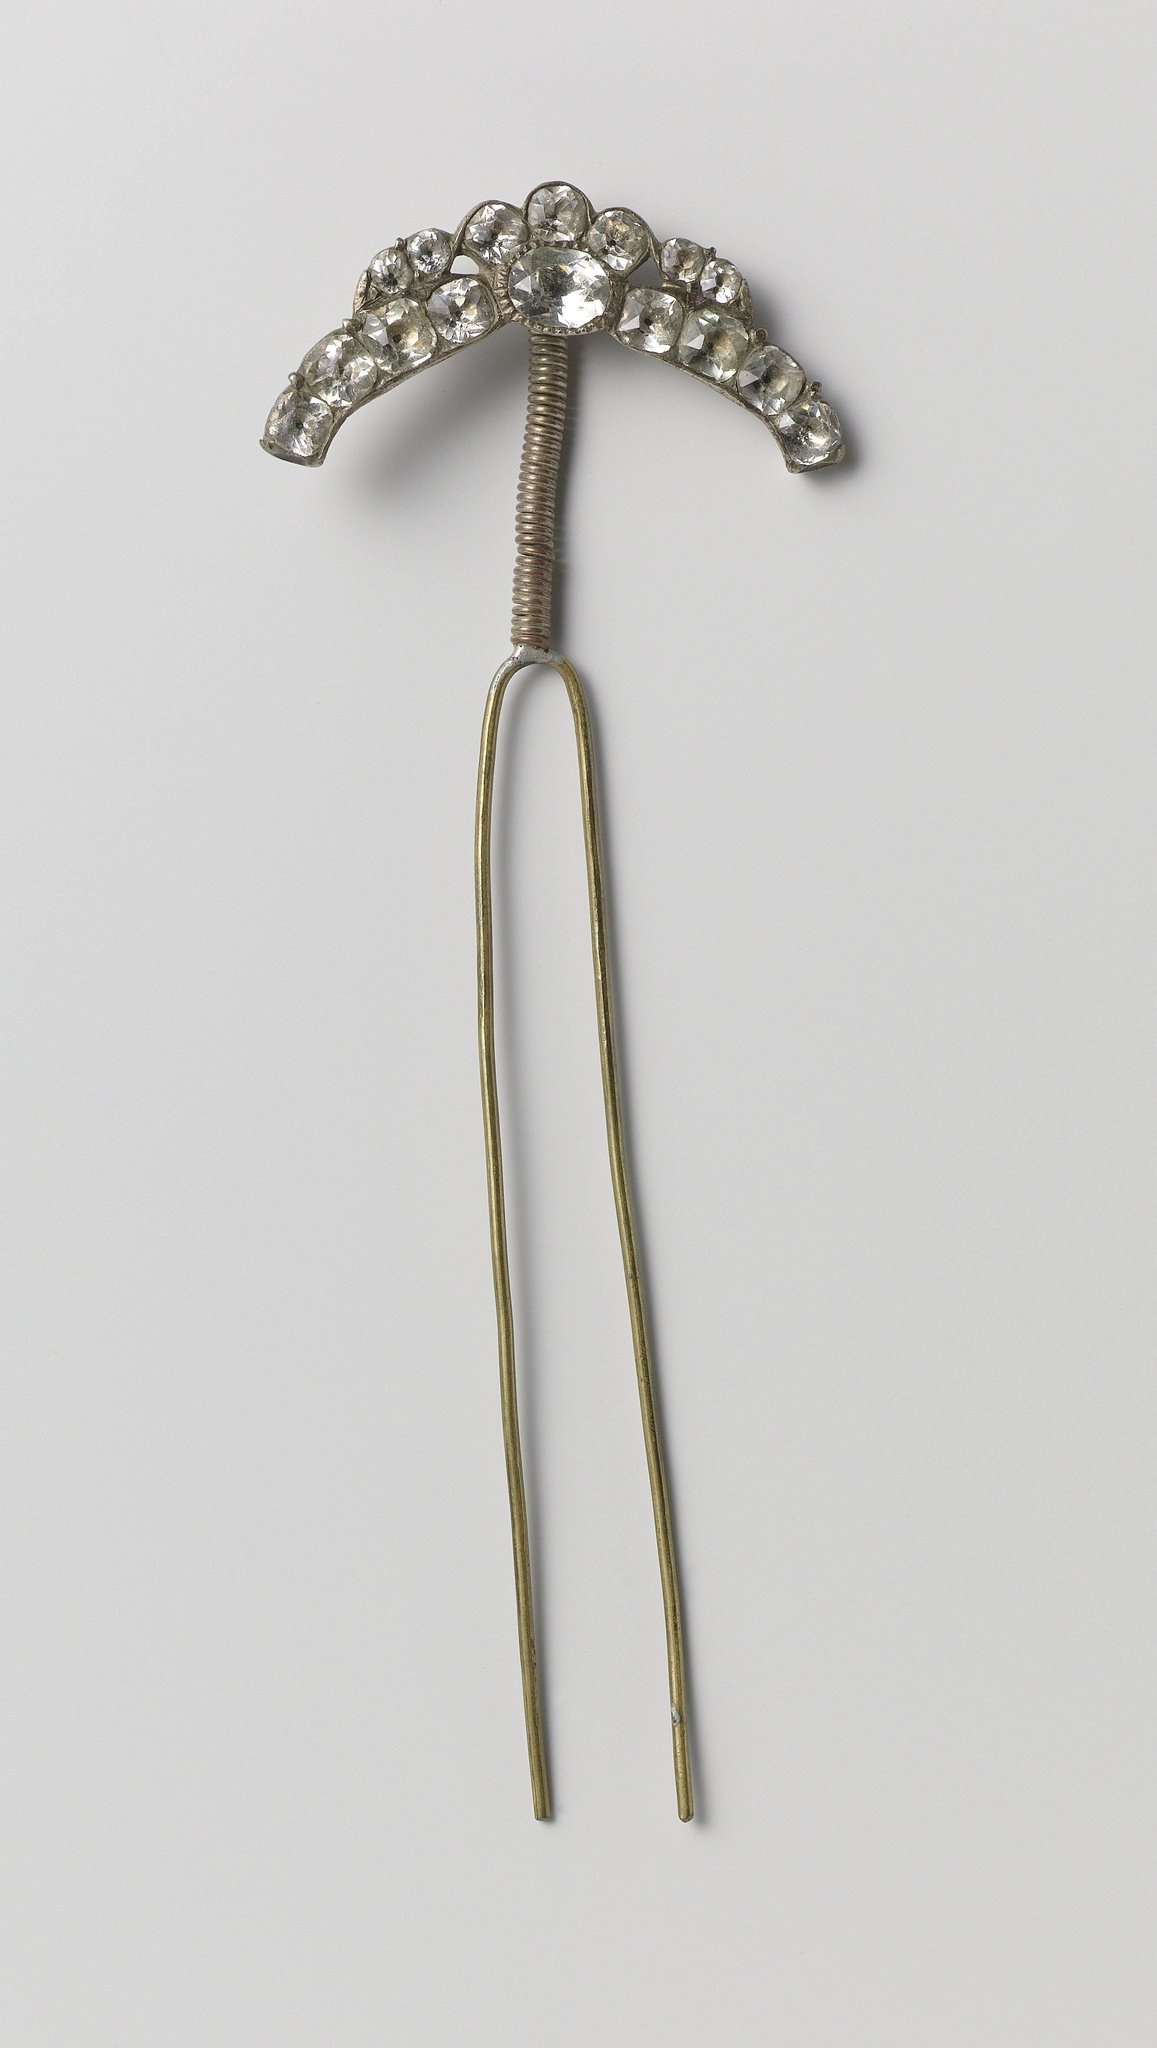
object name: hairpin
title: Haarspeld, tweetand van koper met diadeemvorm van zilver(?) met dubbele rij strasstenen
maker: Anonymous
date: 1900-1910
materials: copper, glass, silver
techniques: forging, grinding, inlay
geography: netherlands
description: Haarspeld (trembleuse) van koper, zilver (?) en stras. Een vorkvormige haarspeld van koper en een dito verlengstuk van een trilveer dragen een kleine diadeemvorm van dubbele rij van grote, diamantgeslepen stenen. De middelste ovaal, de 15 andere rond.